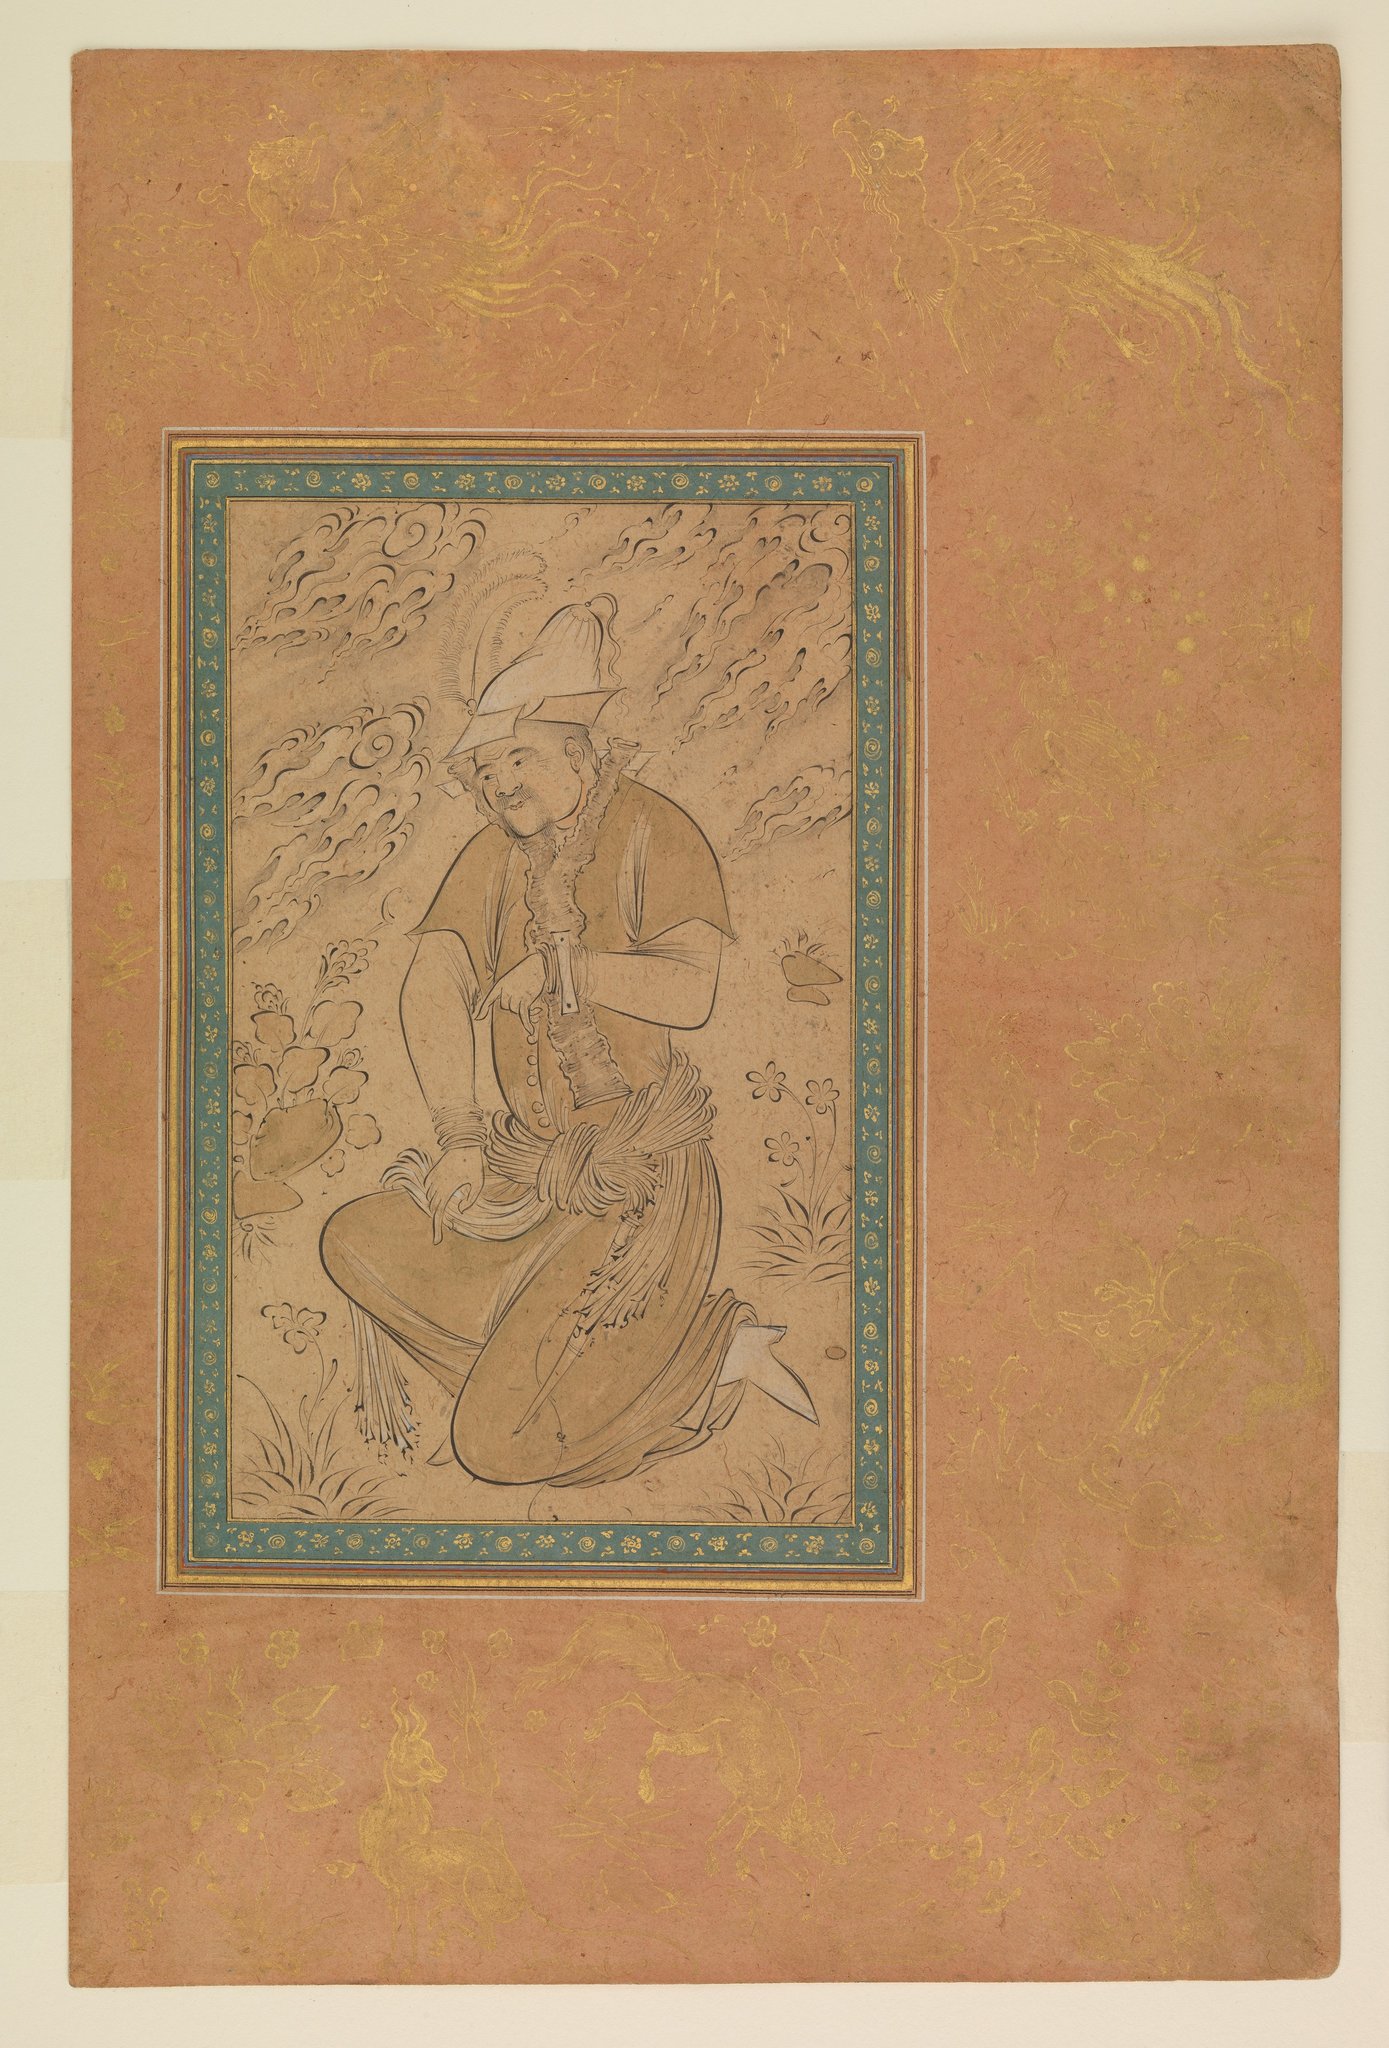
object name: illustrated single work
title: Turkoman Prisoner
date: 1610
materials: ink, paper, watercolor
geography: iran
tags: prisoners,men,portraits